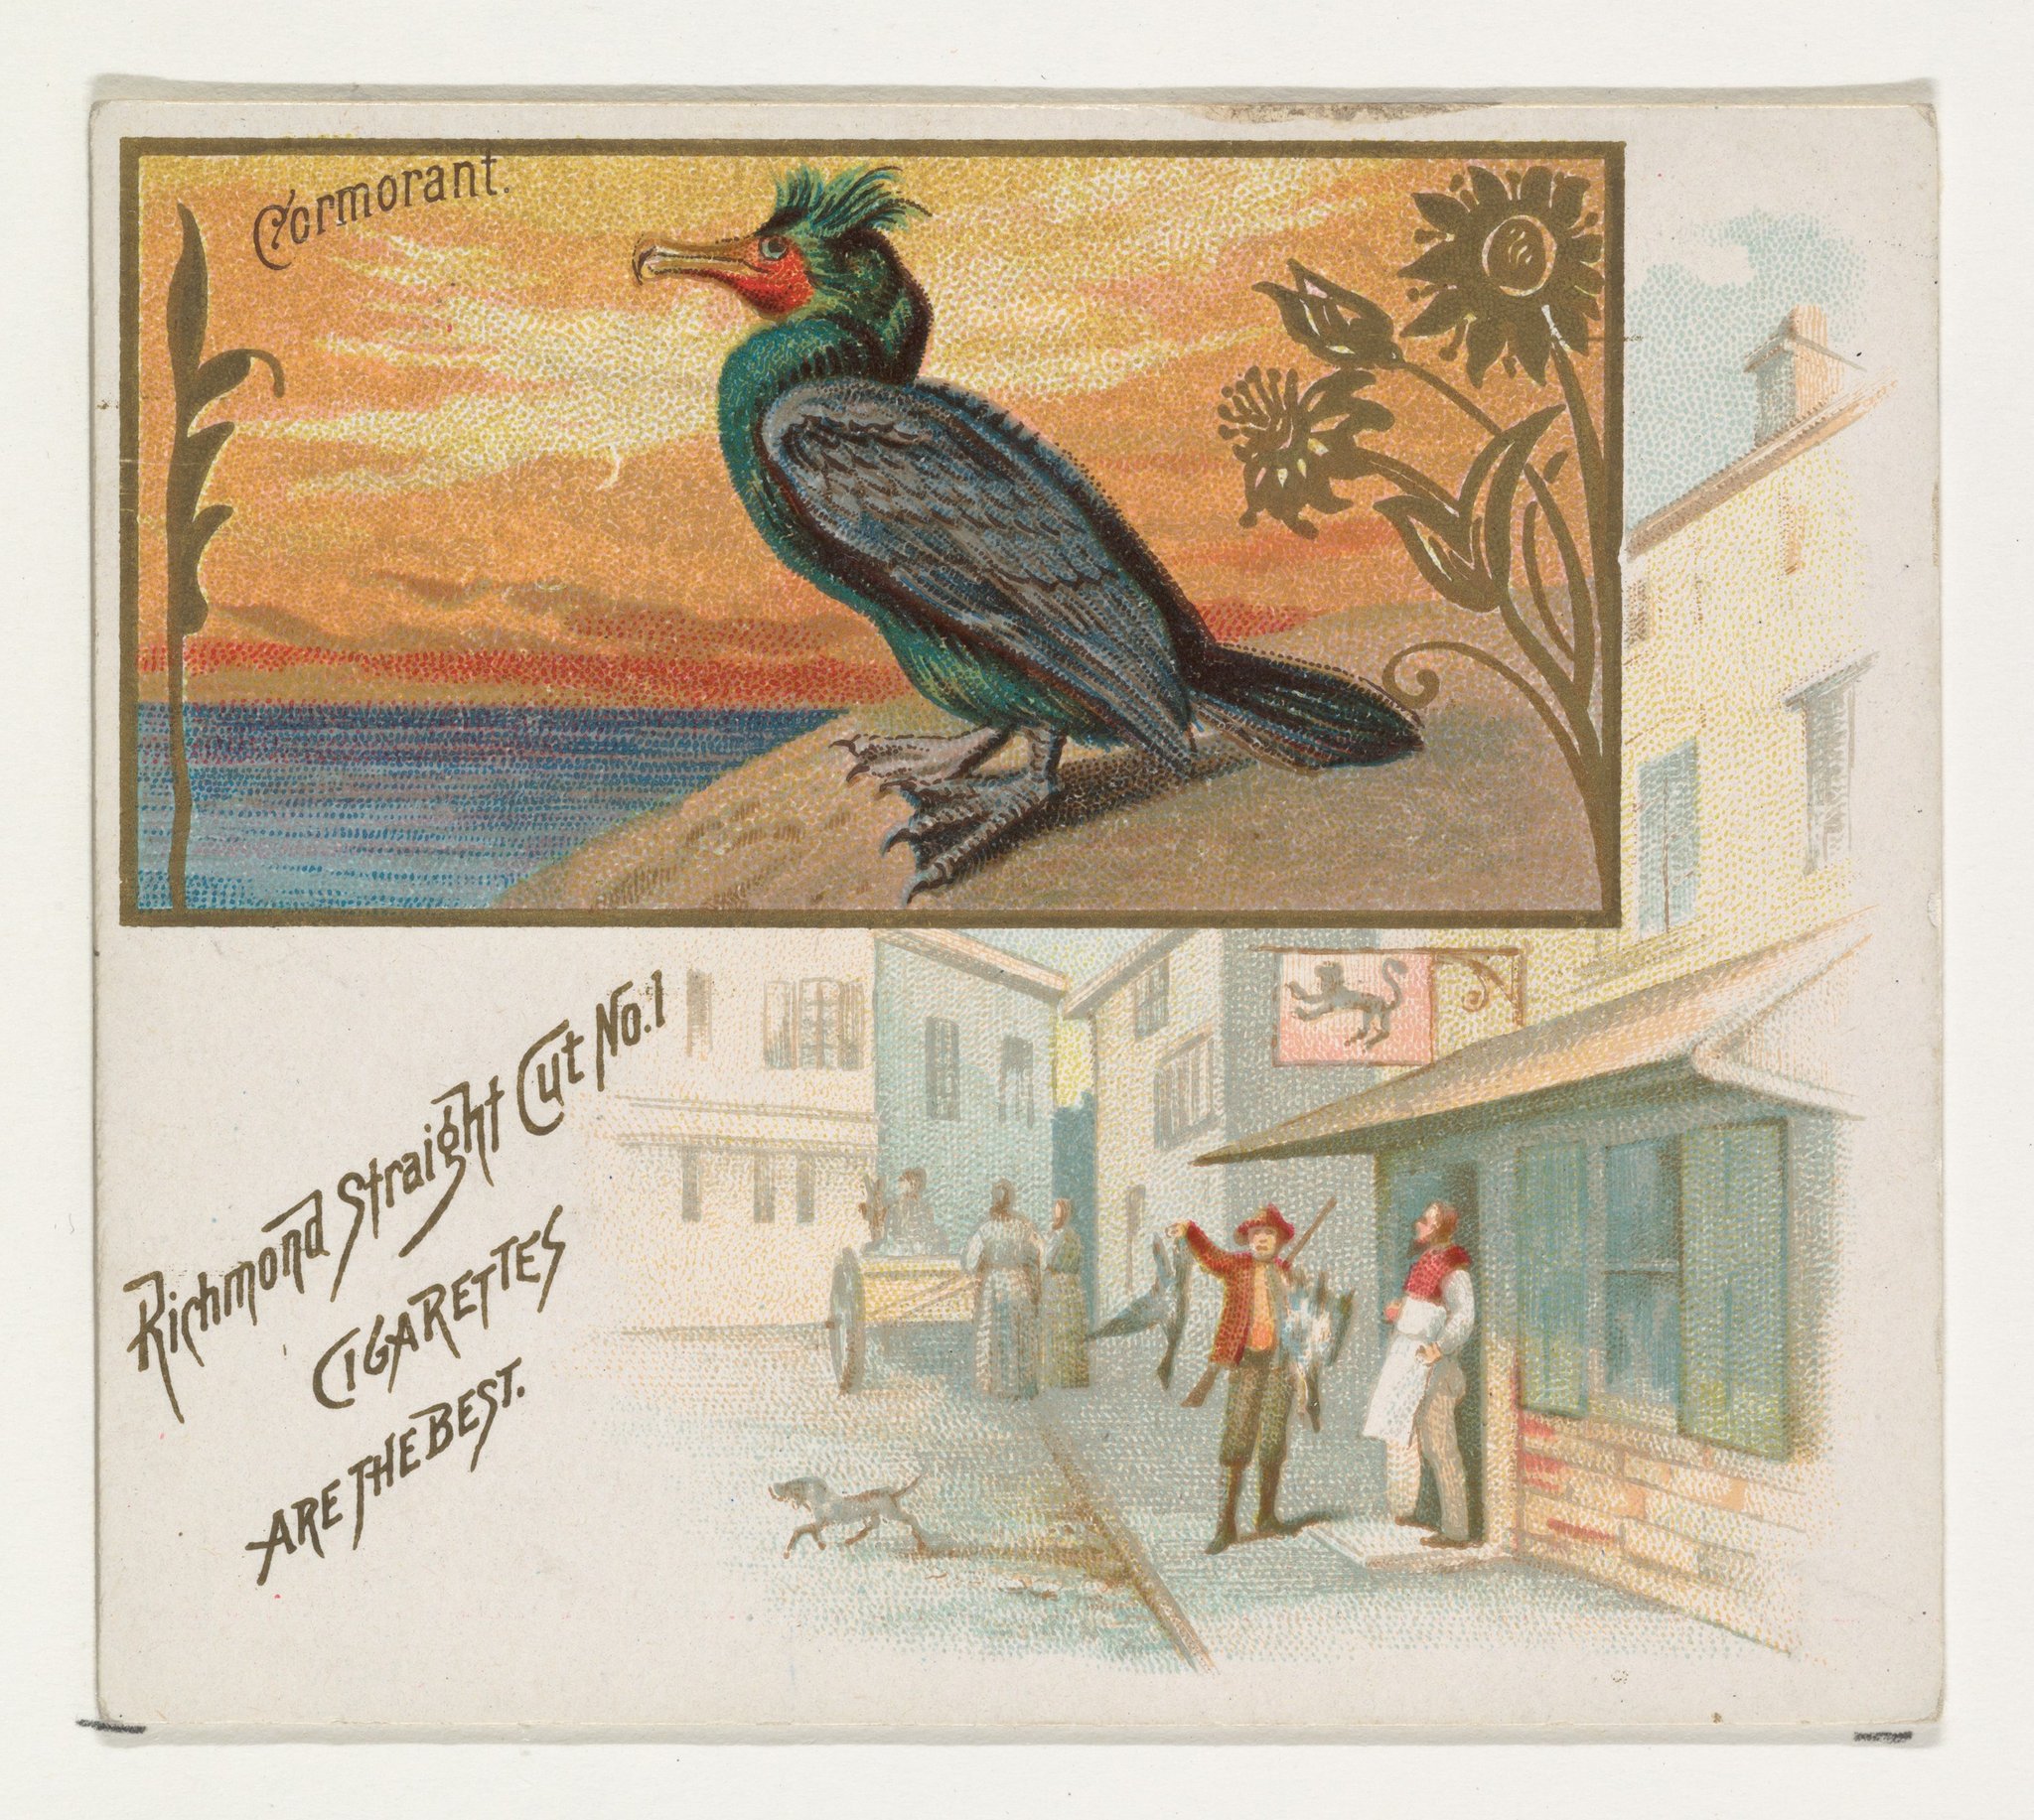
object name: print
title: Cormorant, from the Game Birds series (N40) for Allen & Ginter Cigarettes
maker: allen & ginter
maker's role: publisher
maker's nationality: american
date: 1888-1890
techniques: color lithograph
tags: birds